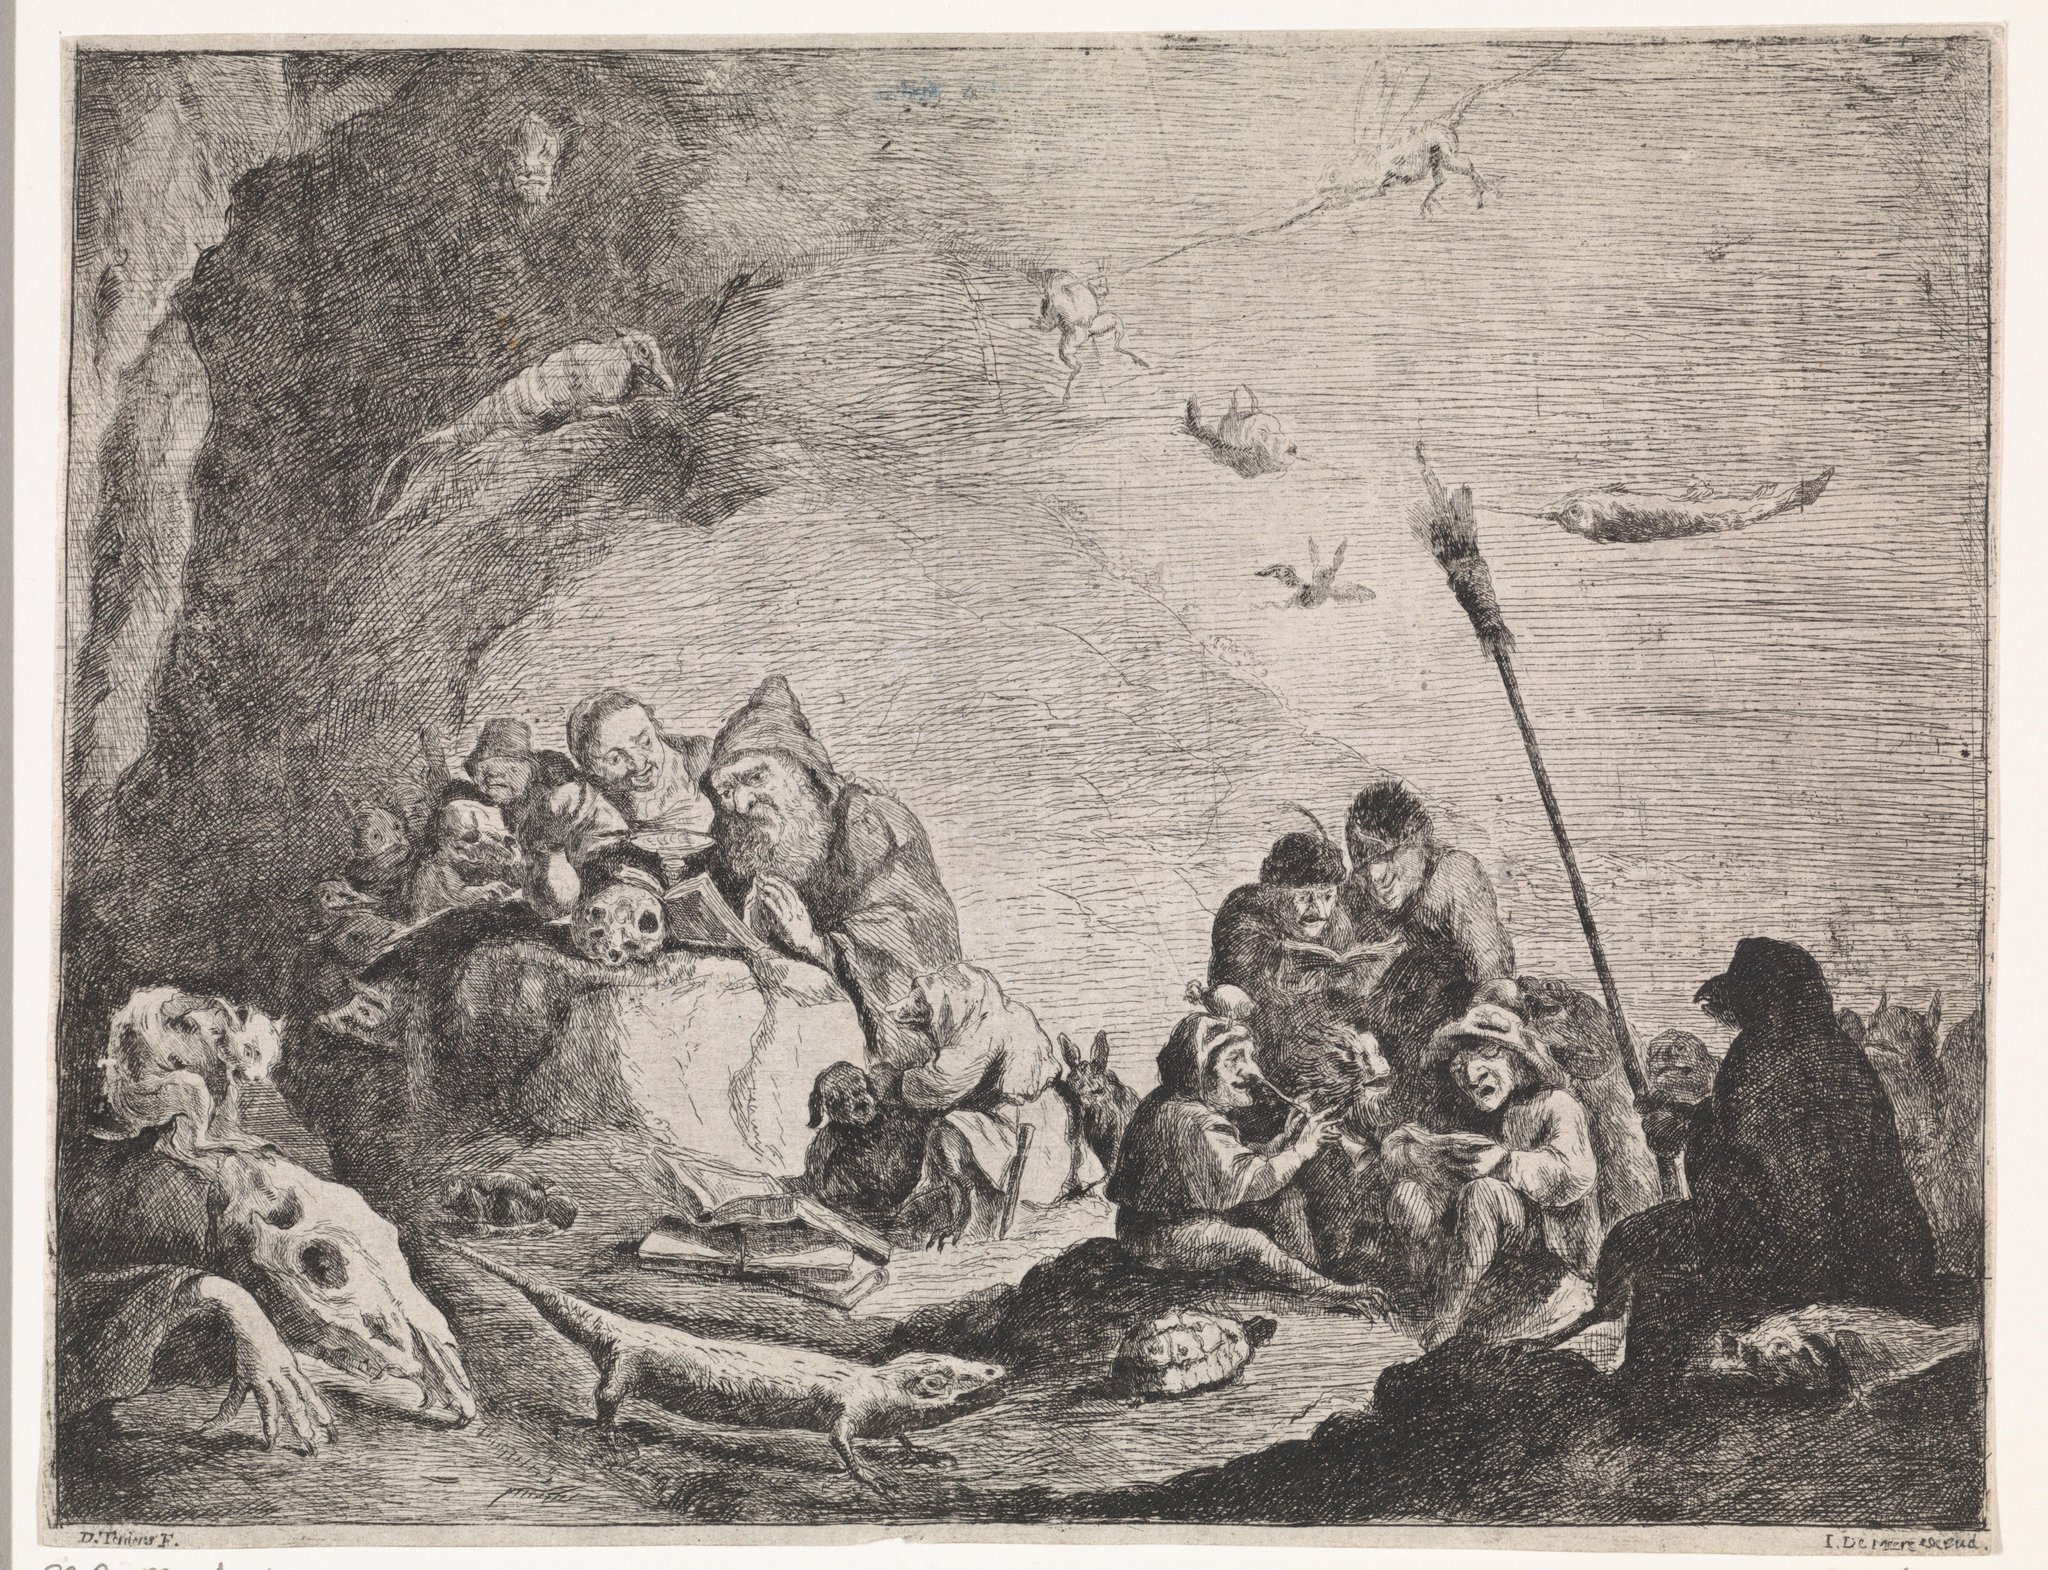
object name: print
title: Verzoeking van de H. Antonius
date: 1790-1810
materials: paper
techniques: etching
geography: low countries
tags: st. antony abbot tormented by devils, attacking him on the ground or carrying him aloft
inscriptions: collector's mark: Lugt 2228, collector's mark: Lugt 2610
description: De heilige Antonius zit in een grot geknield achter een rots en leest zijn gebedsboek, terwijl boze geesten hem belagen. Rechts een monster met een bezemsteel.